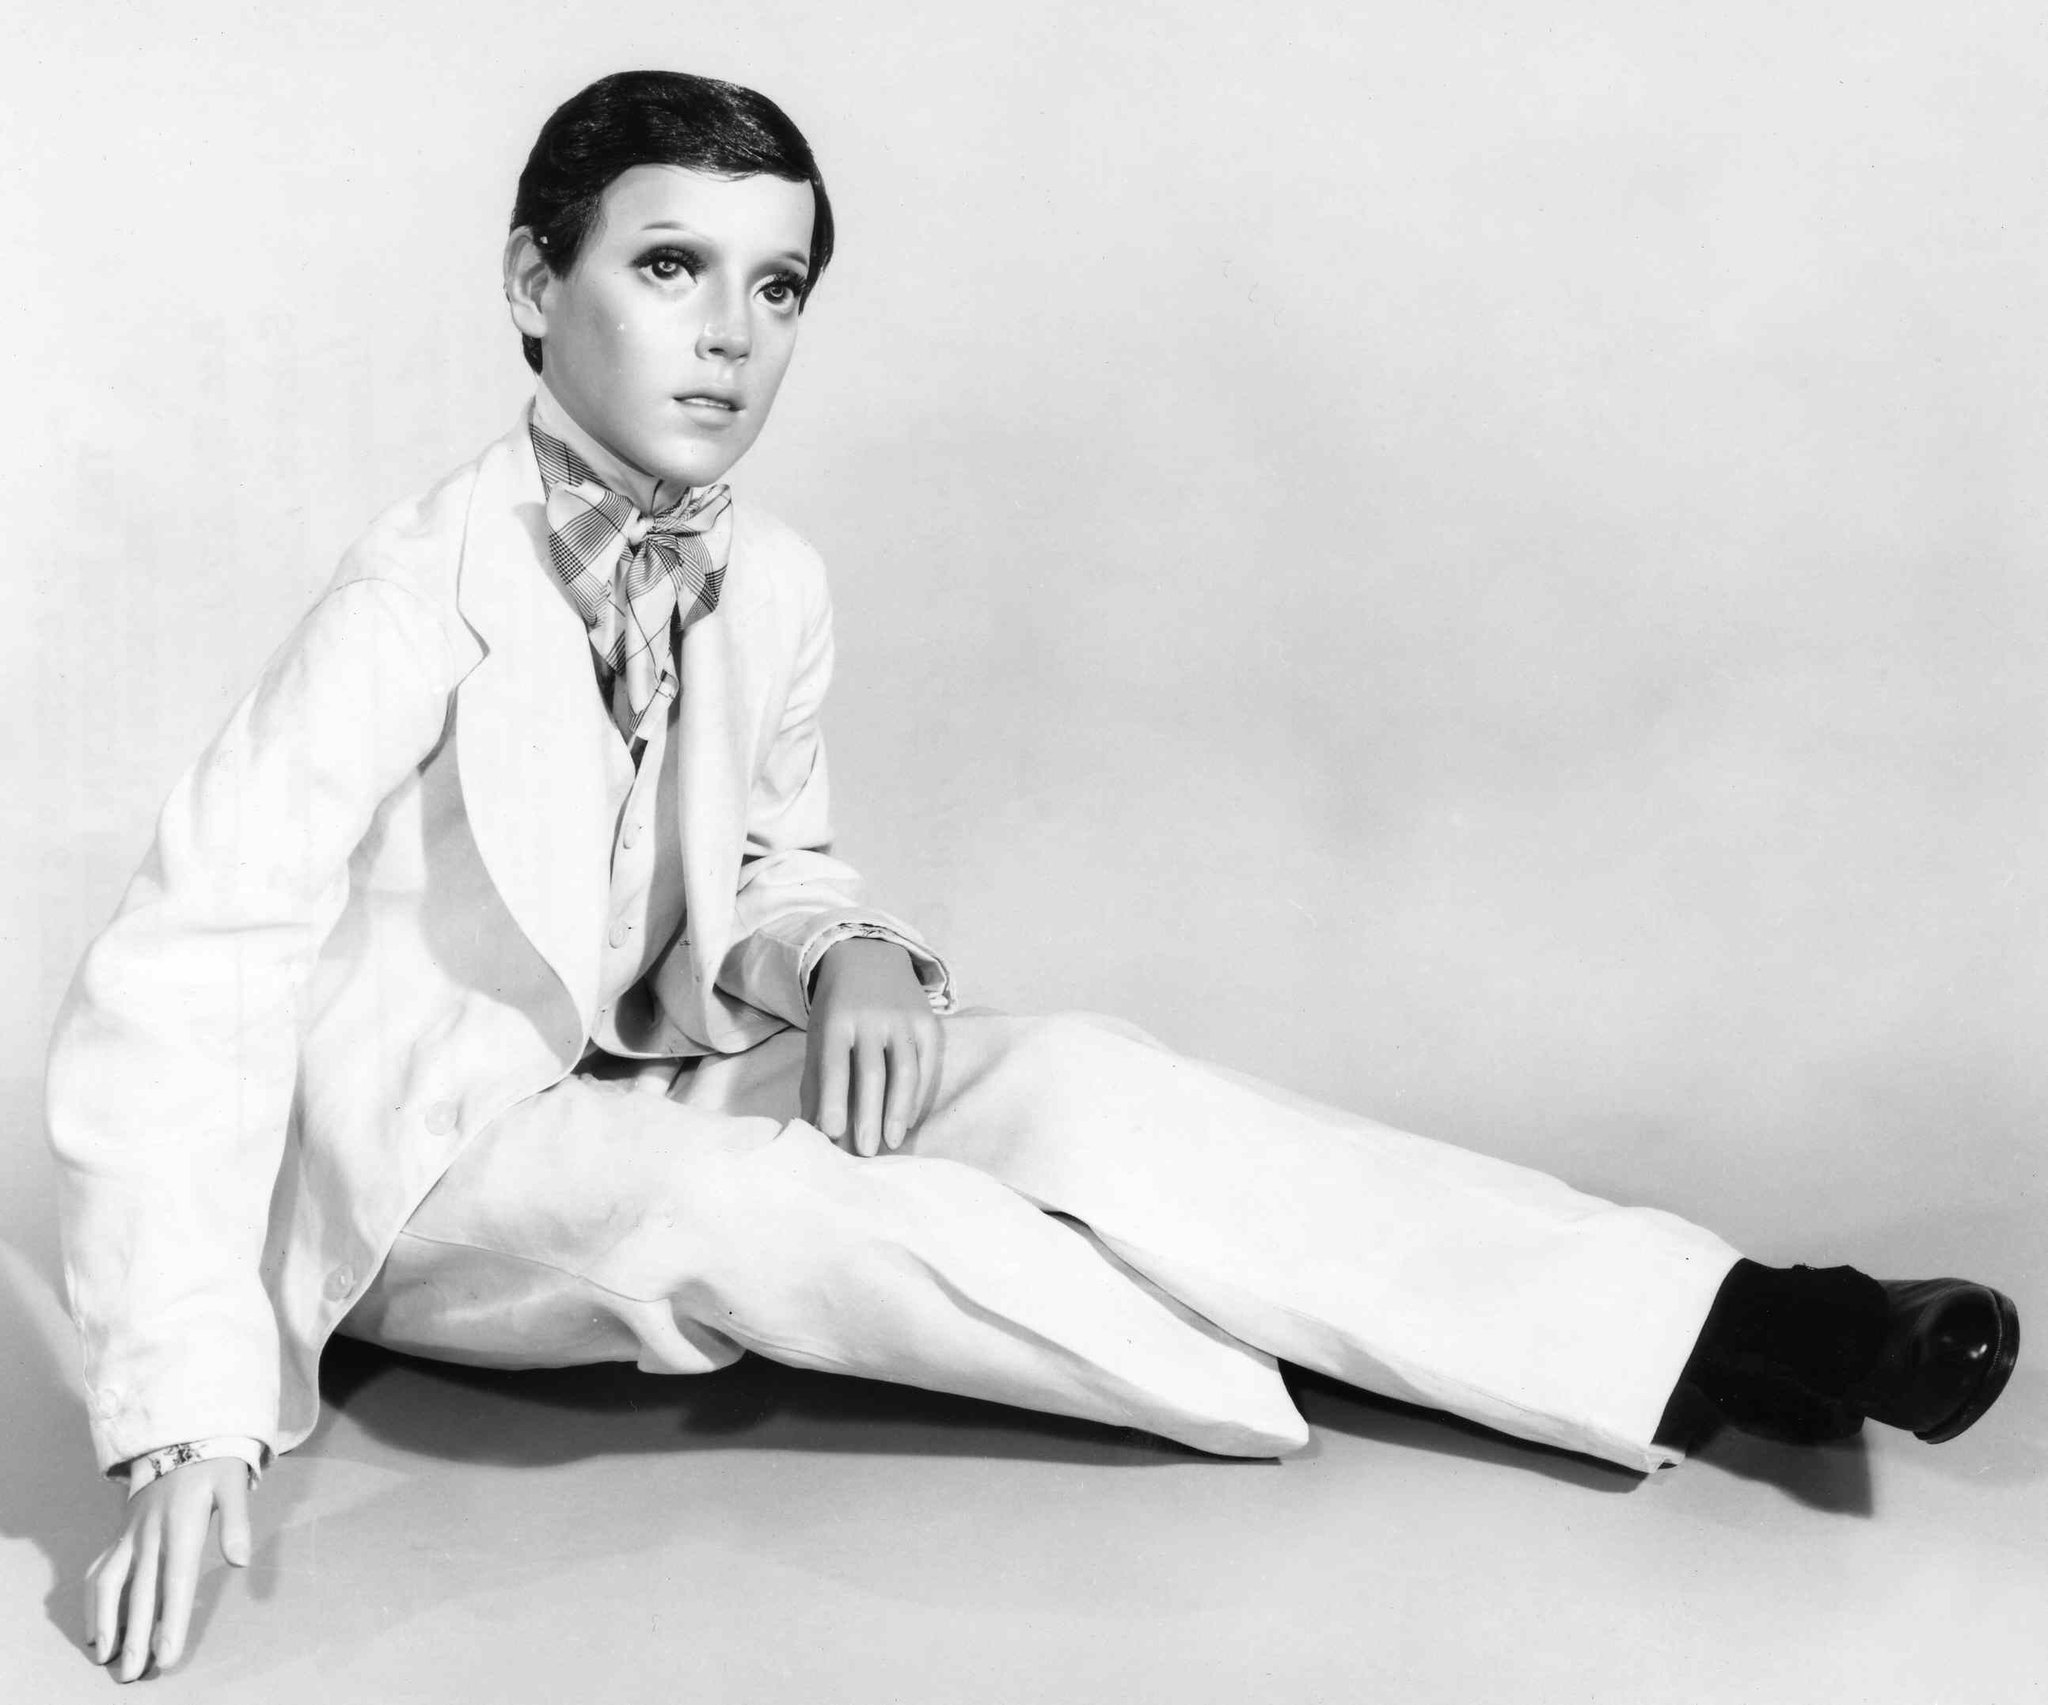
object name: suit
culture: american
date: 1860-1869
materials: cotton, linen